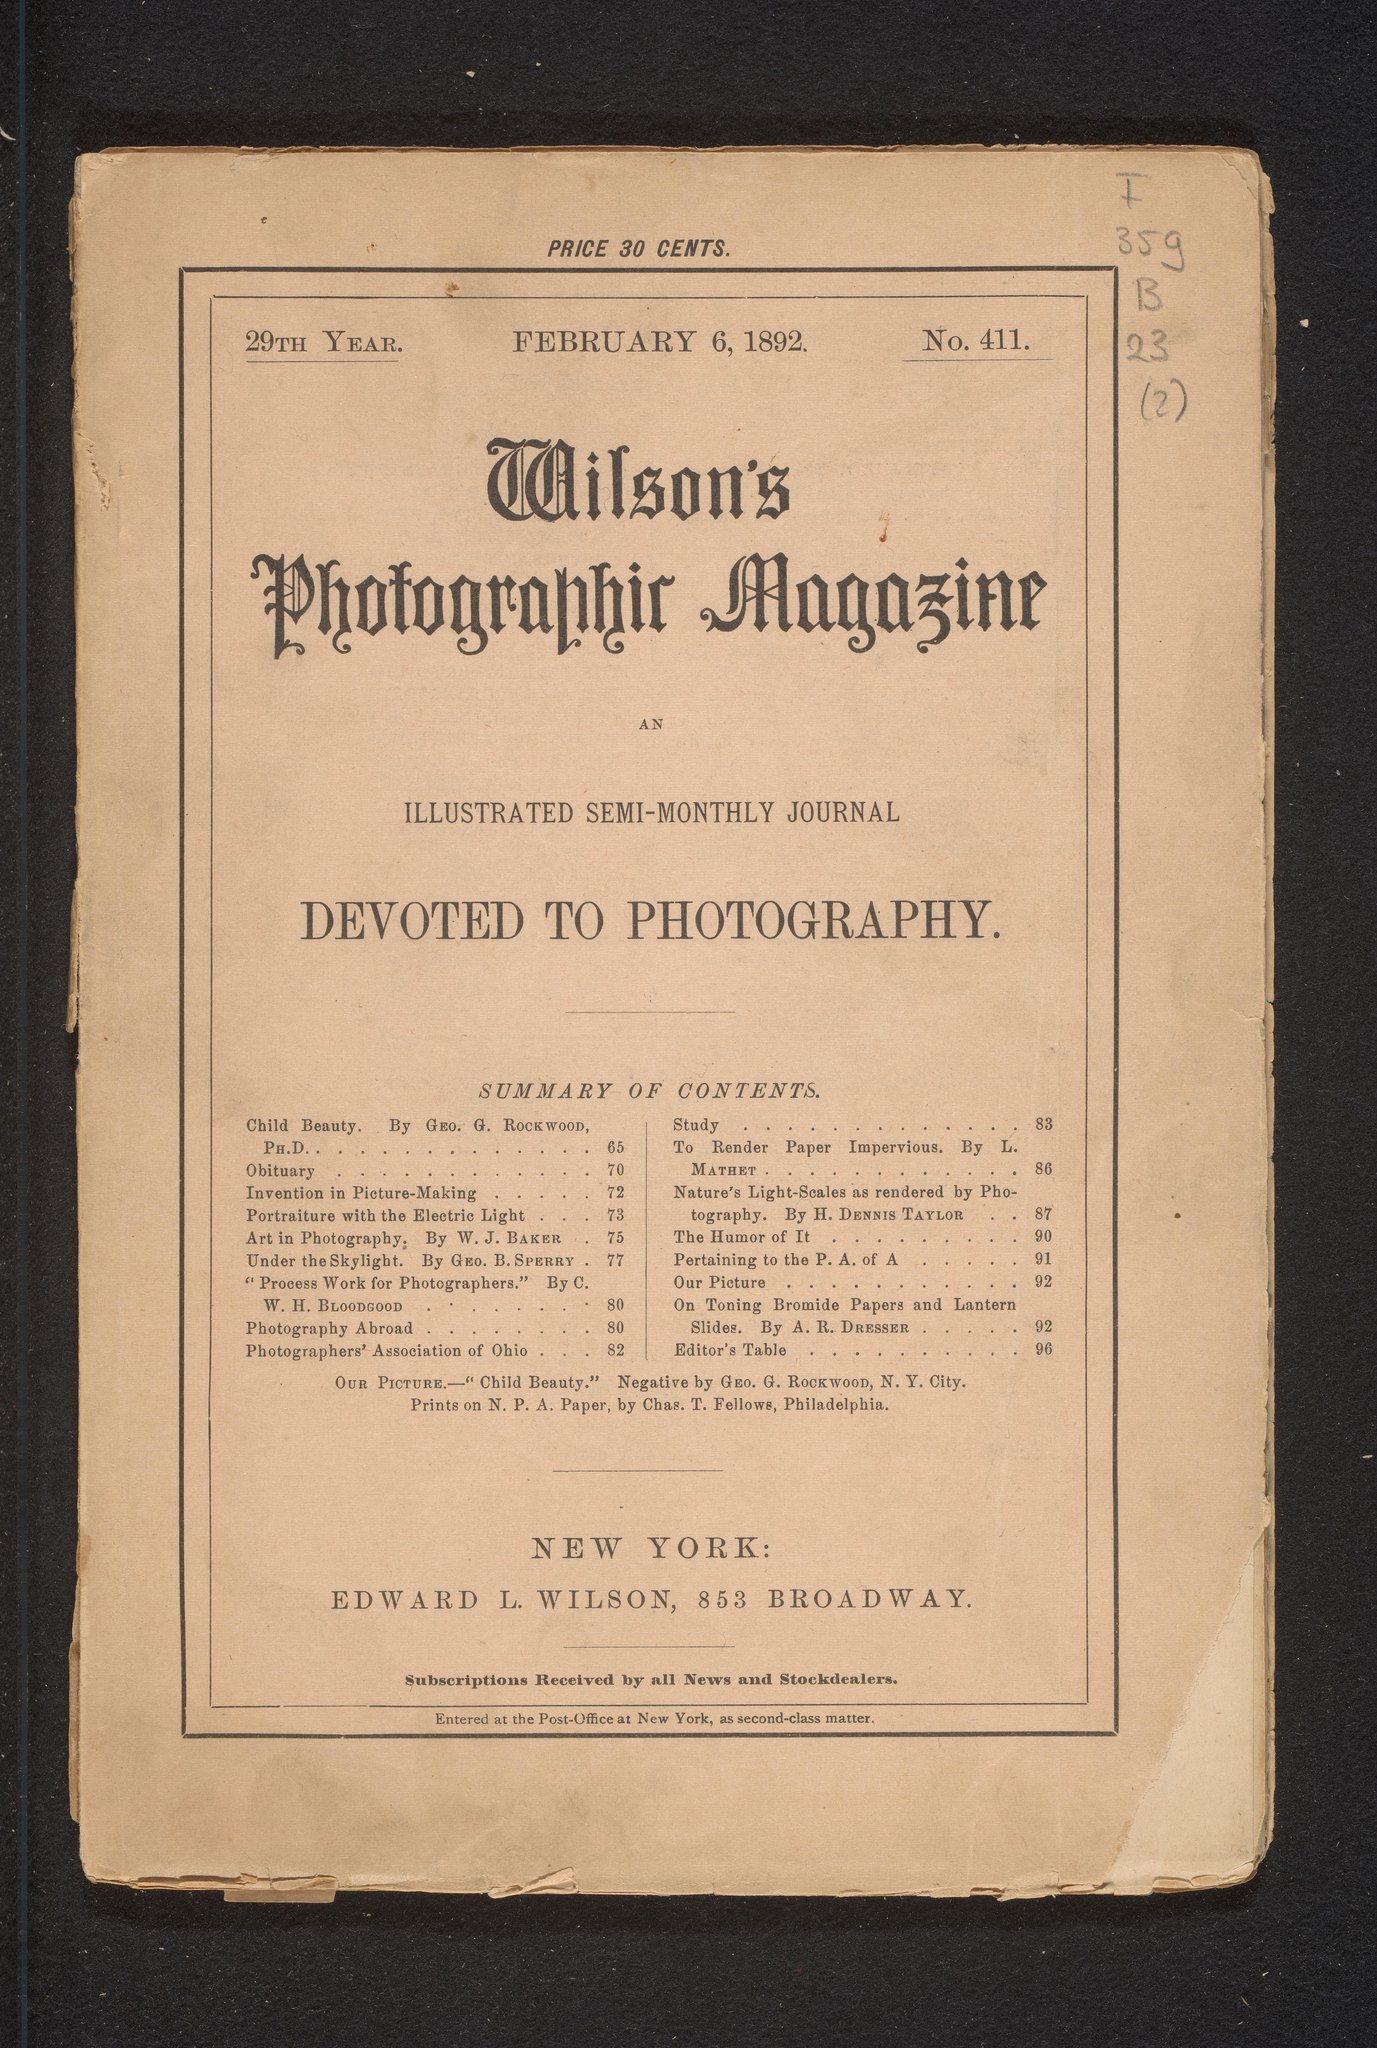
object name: magazine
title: Wilson's photographic magazine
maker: edward livingston wilson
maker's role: publisher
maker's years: 1838-1903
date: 1892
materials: paper, photographic support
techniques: albumen print, printing, printing block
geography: new york city